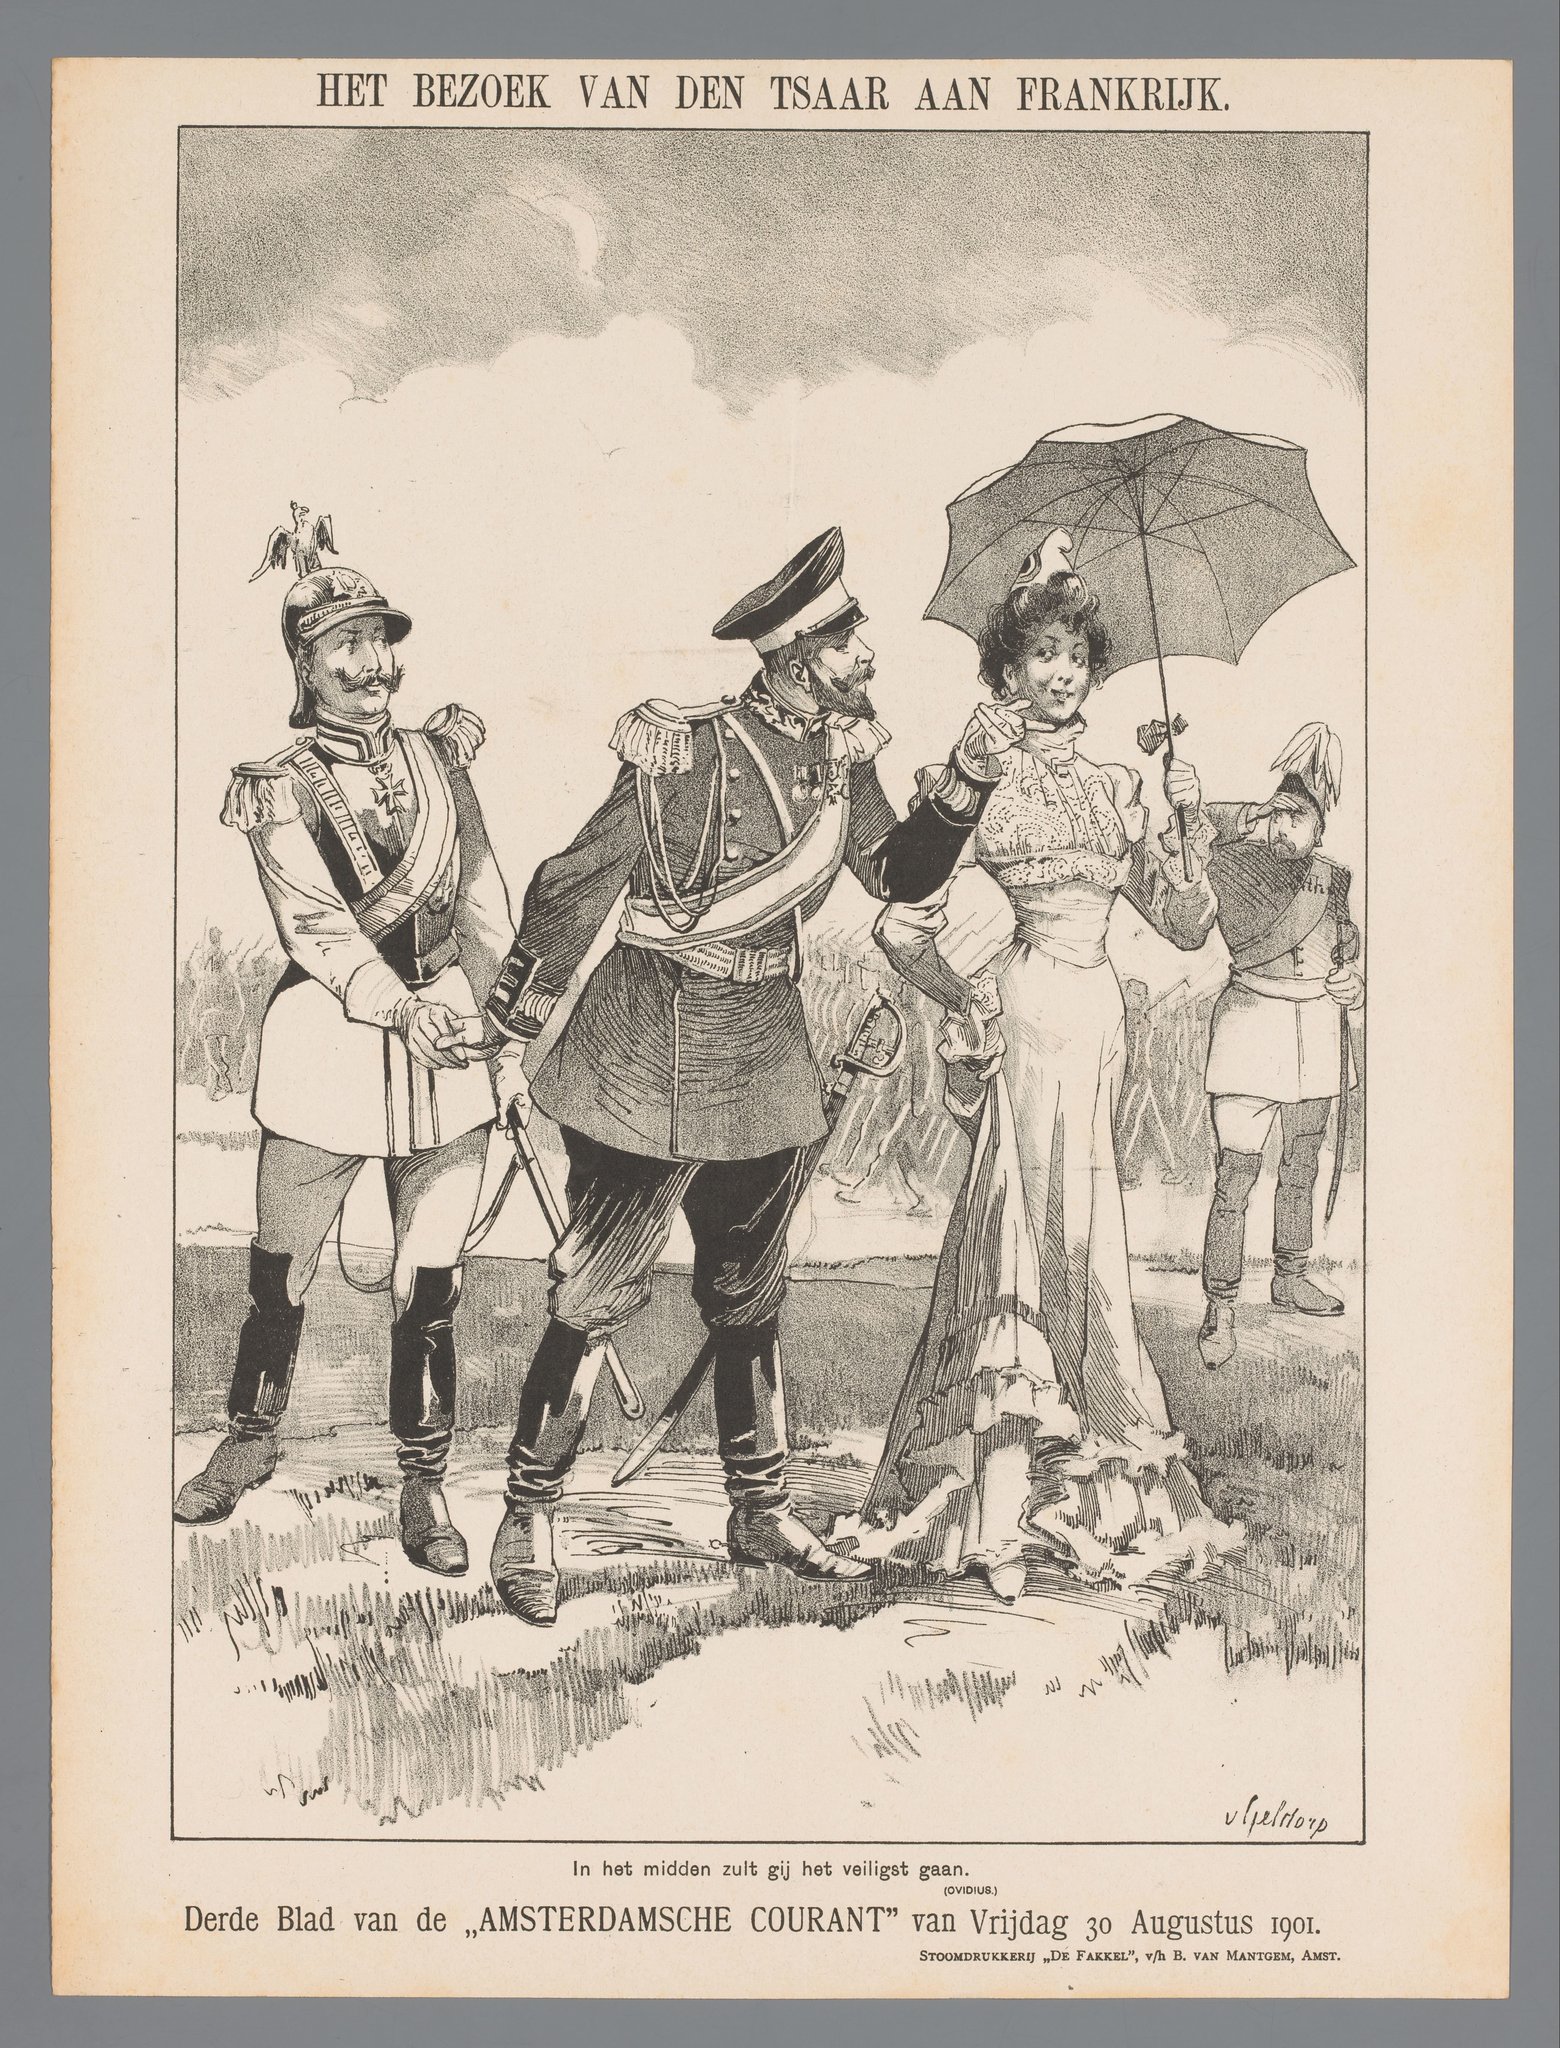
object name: cartoon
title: Het bezoek van den tsaar aan Frankrijk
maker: petrus van geldorp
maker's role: draughtsman, print maker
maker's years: 1872-1939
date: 1901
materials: paper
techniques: lithograph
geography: amsterdam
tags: wilhelm ii (keizer van duitsland), personifications of countries, nations, states, districts, etc., ruler, sovereign, political caricatures and satires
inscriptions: date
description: Prent uit het bijvoegsel van: De Amsterdamsche Courant, 30 augustus 1901.